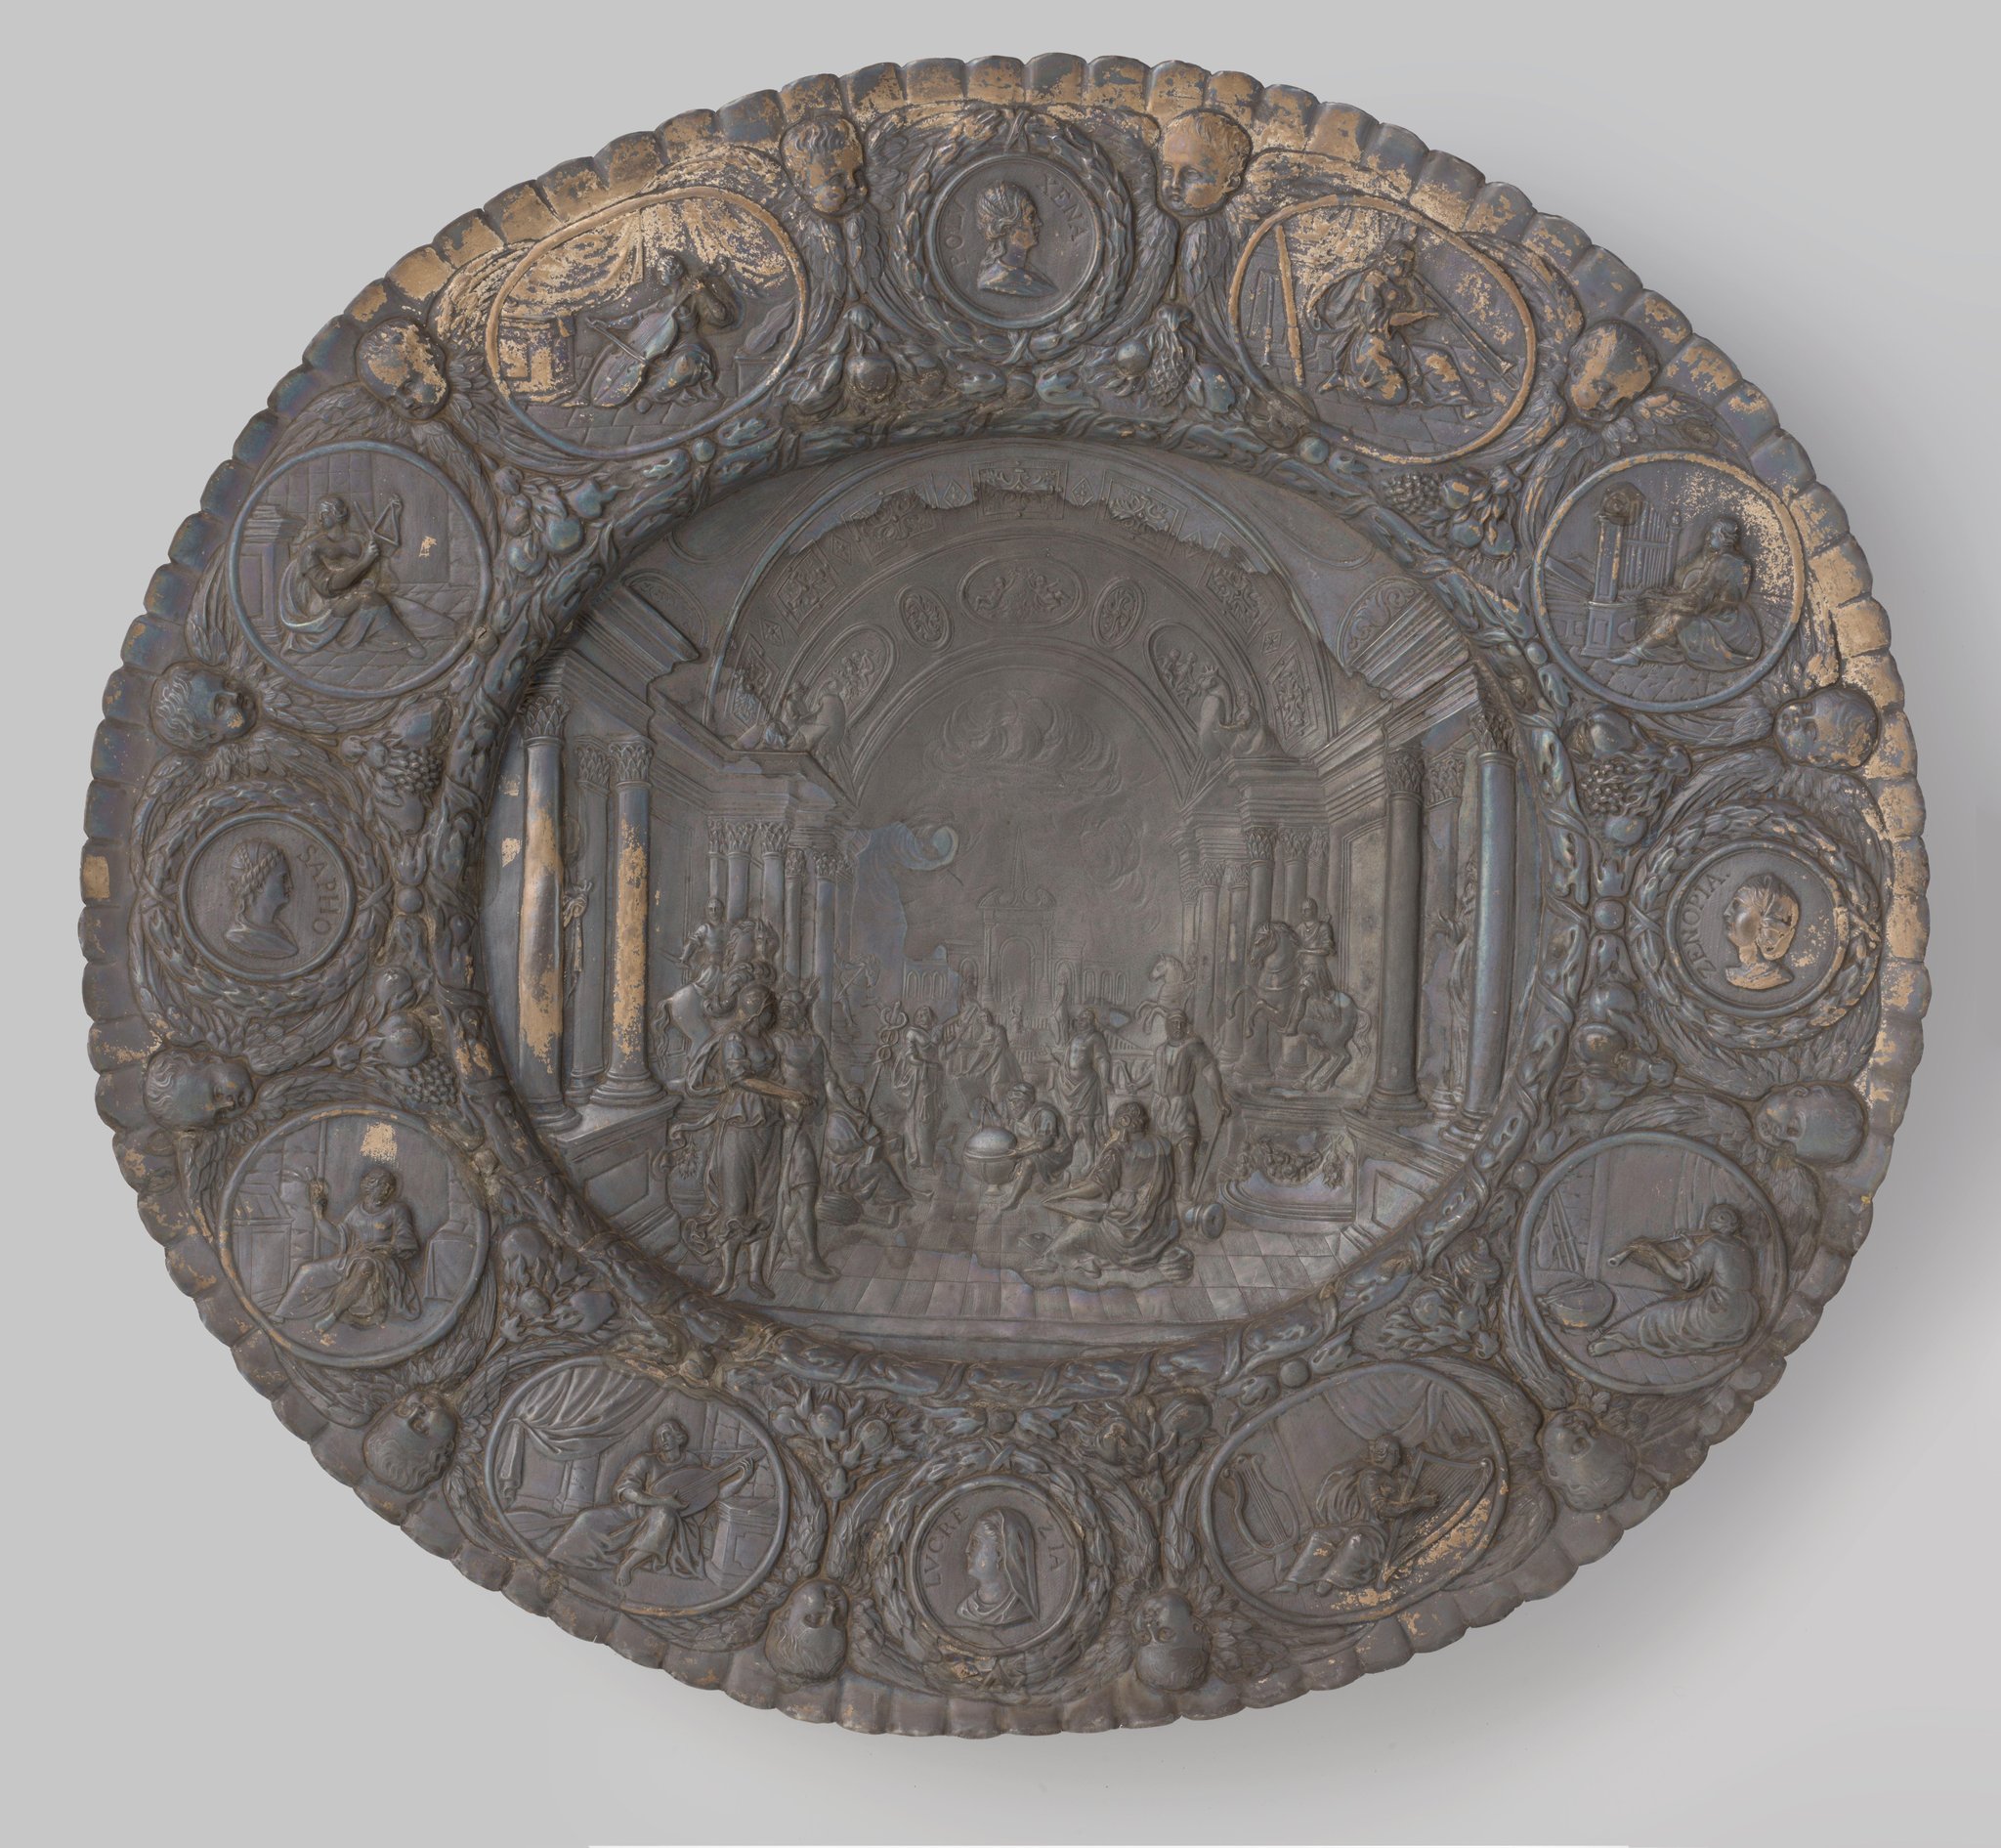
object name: platter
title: Schotel met de school van Athene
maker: Anonymous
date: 1600-1699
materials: silver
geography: germany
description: Schotel met de school van Athene. Op de rand de busten van Poluxena, Zenophia, Sapho en Lucretia. Verder de muziek, voorgesteld door acht vrouwen, op verschillende instrumenten spelende.